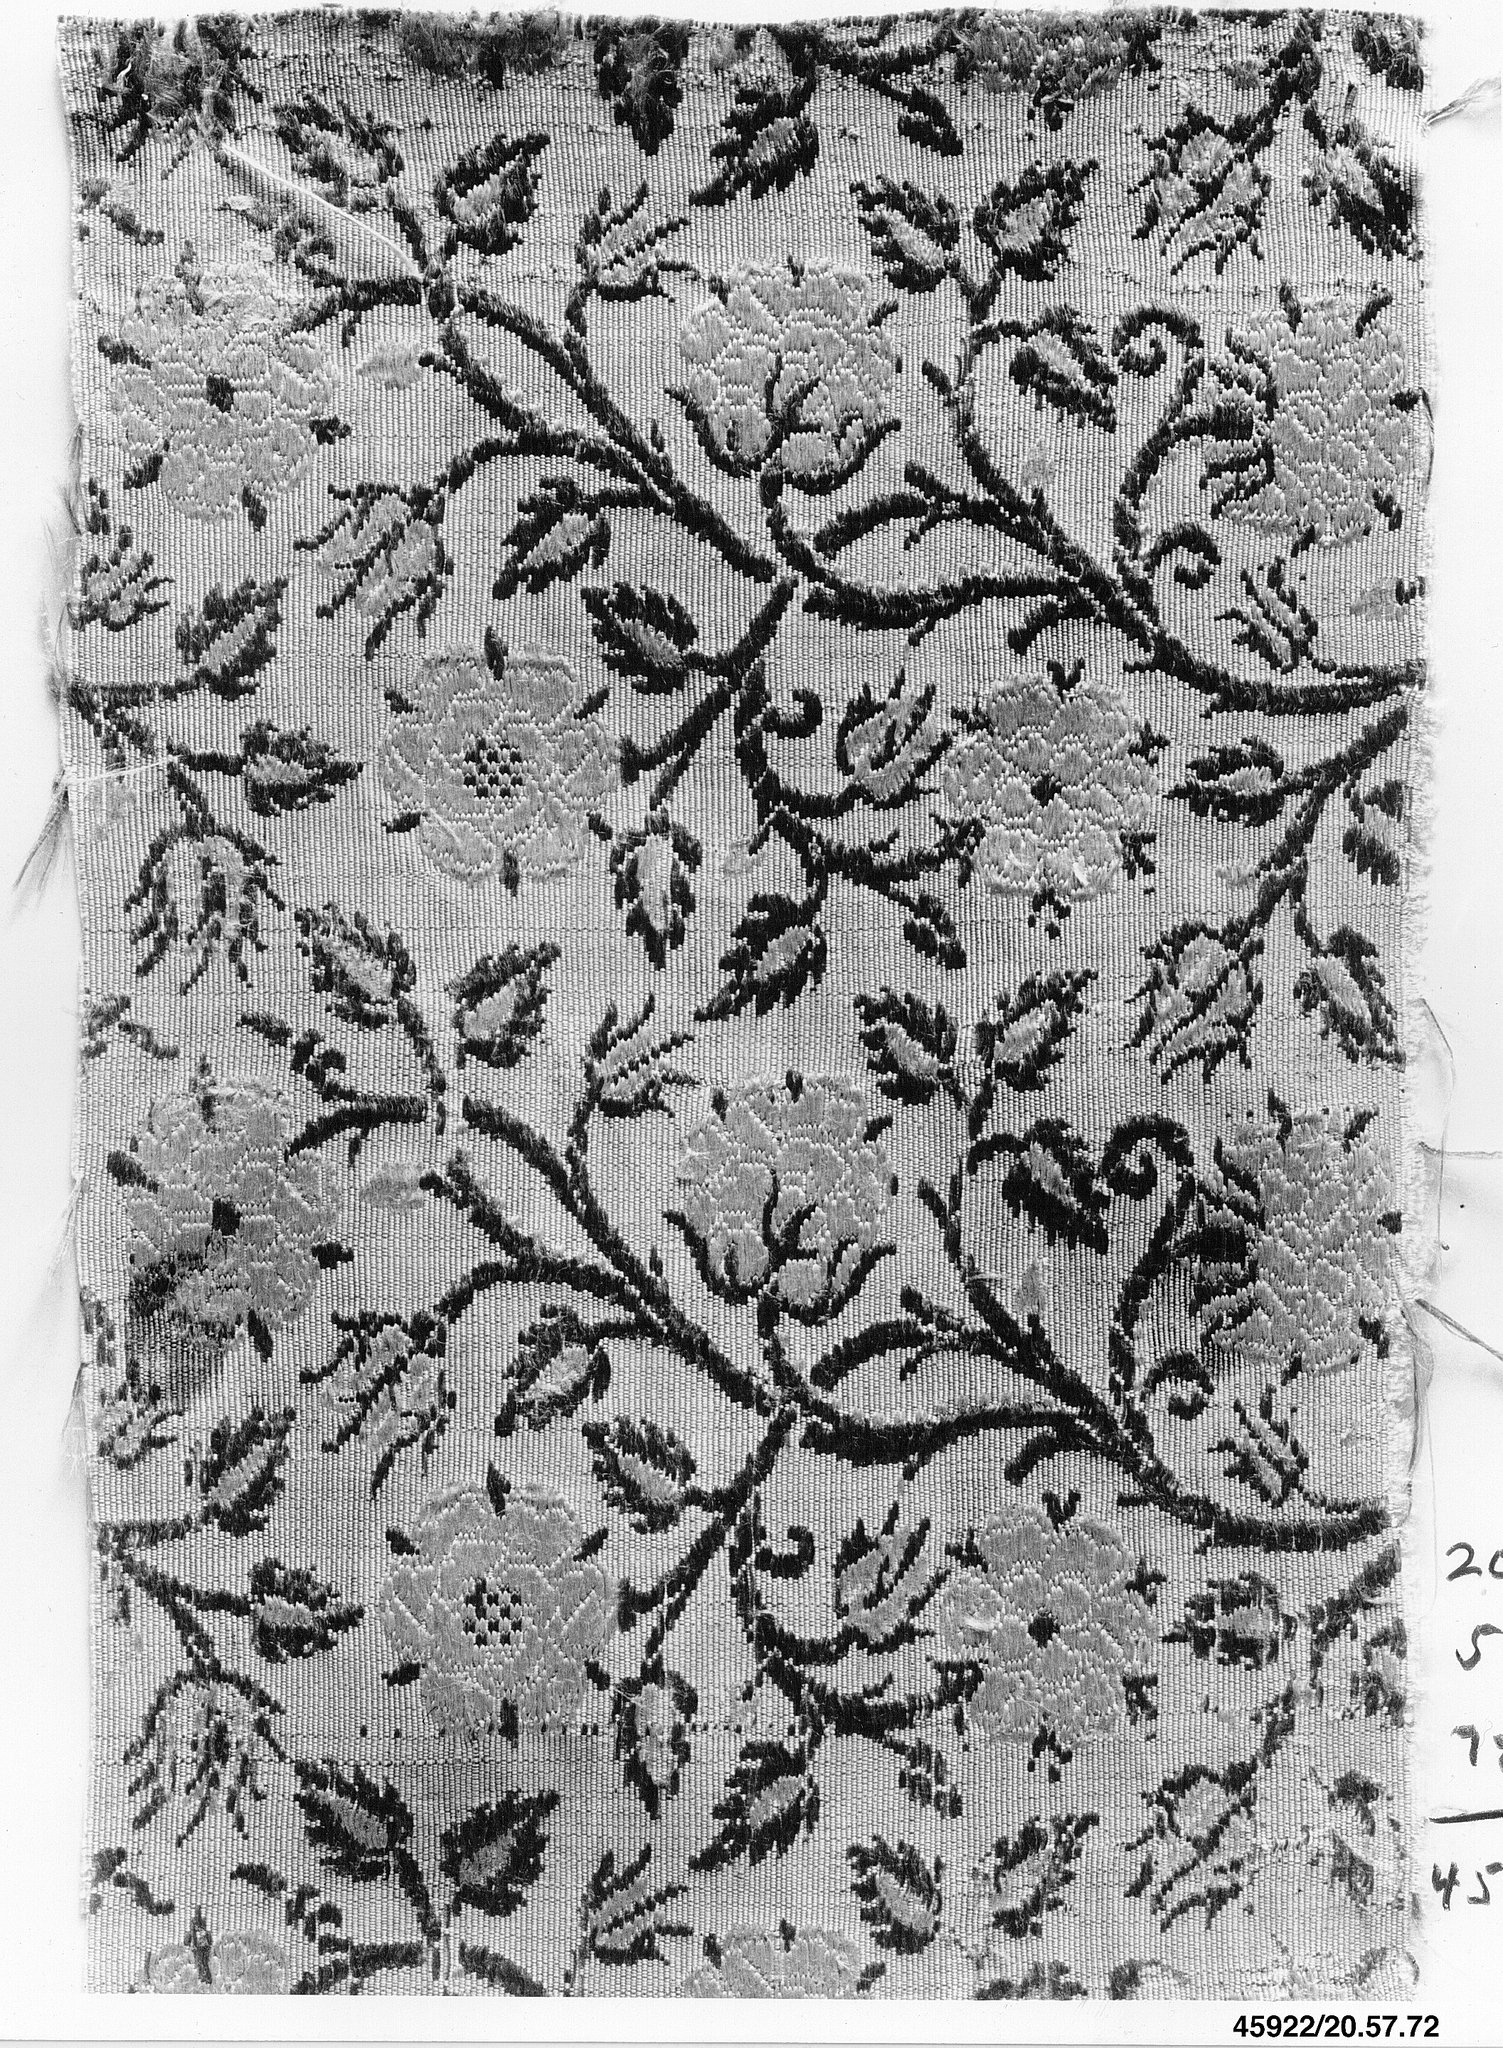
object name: piece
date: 1750-1760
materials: silk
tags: flowers,leaves